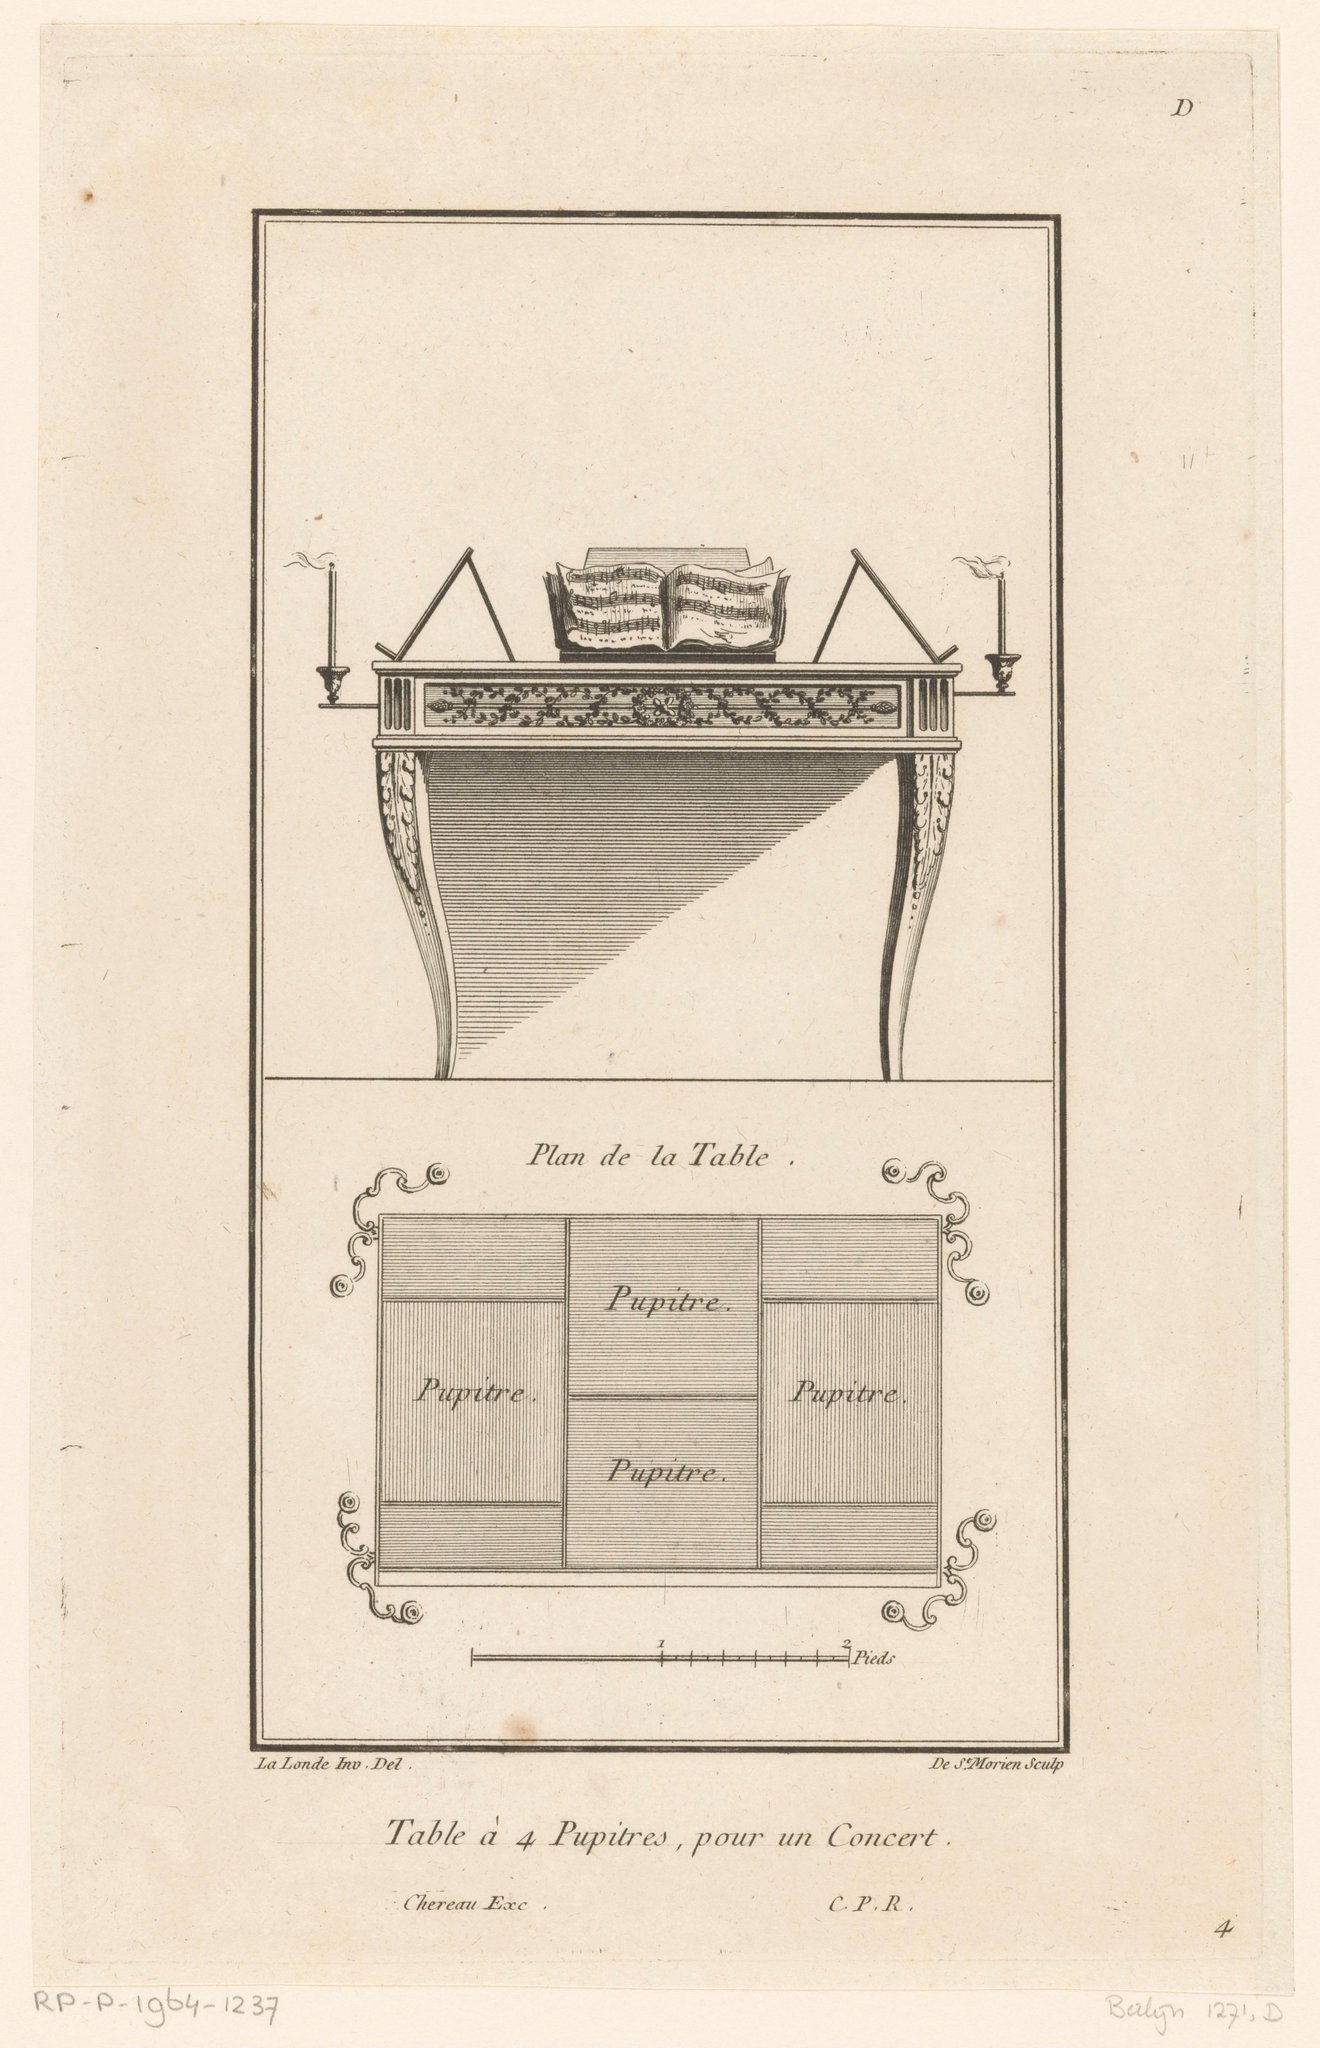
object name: print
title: D Quatrieme Cahier de Meubles et d'Ébénisteries, Dessin's par La Londe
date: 1784-1785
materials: paper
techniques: etching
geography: paris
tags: table, accessories ~ music: metronome, music-stand, tuning-fork, etc.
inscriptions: collector's mark: Lugt 2228, collector's mark: Lugt 2760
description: Een tafel met kandelaars en vier muziekstandaards. De tafel is met ranken, thyrsi en bladmotieven gedecoreerd.